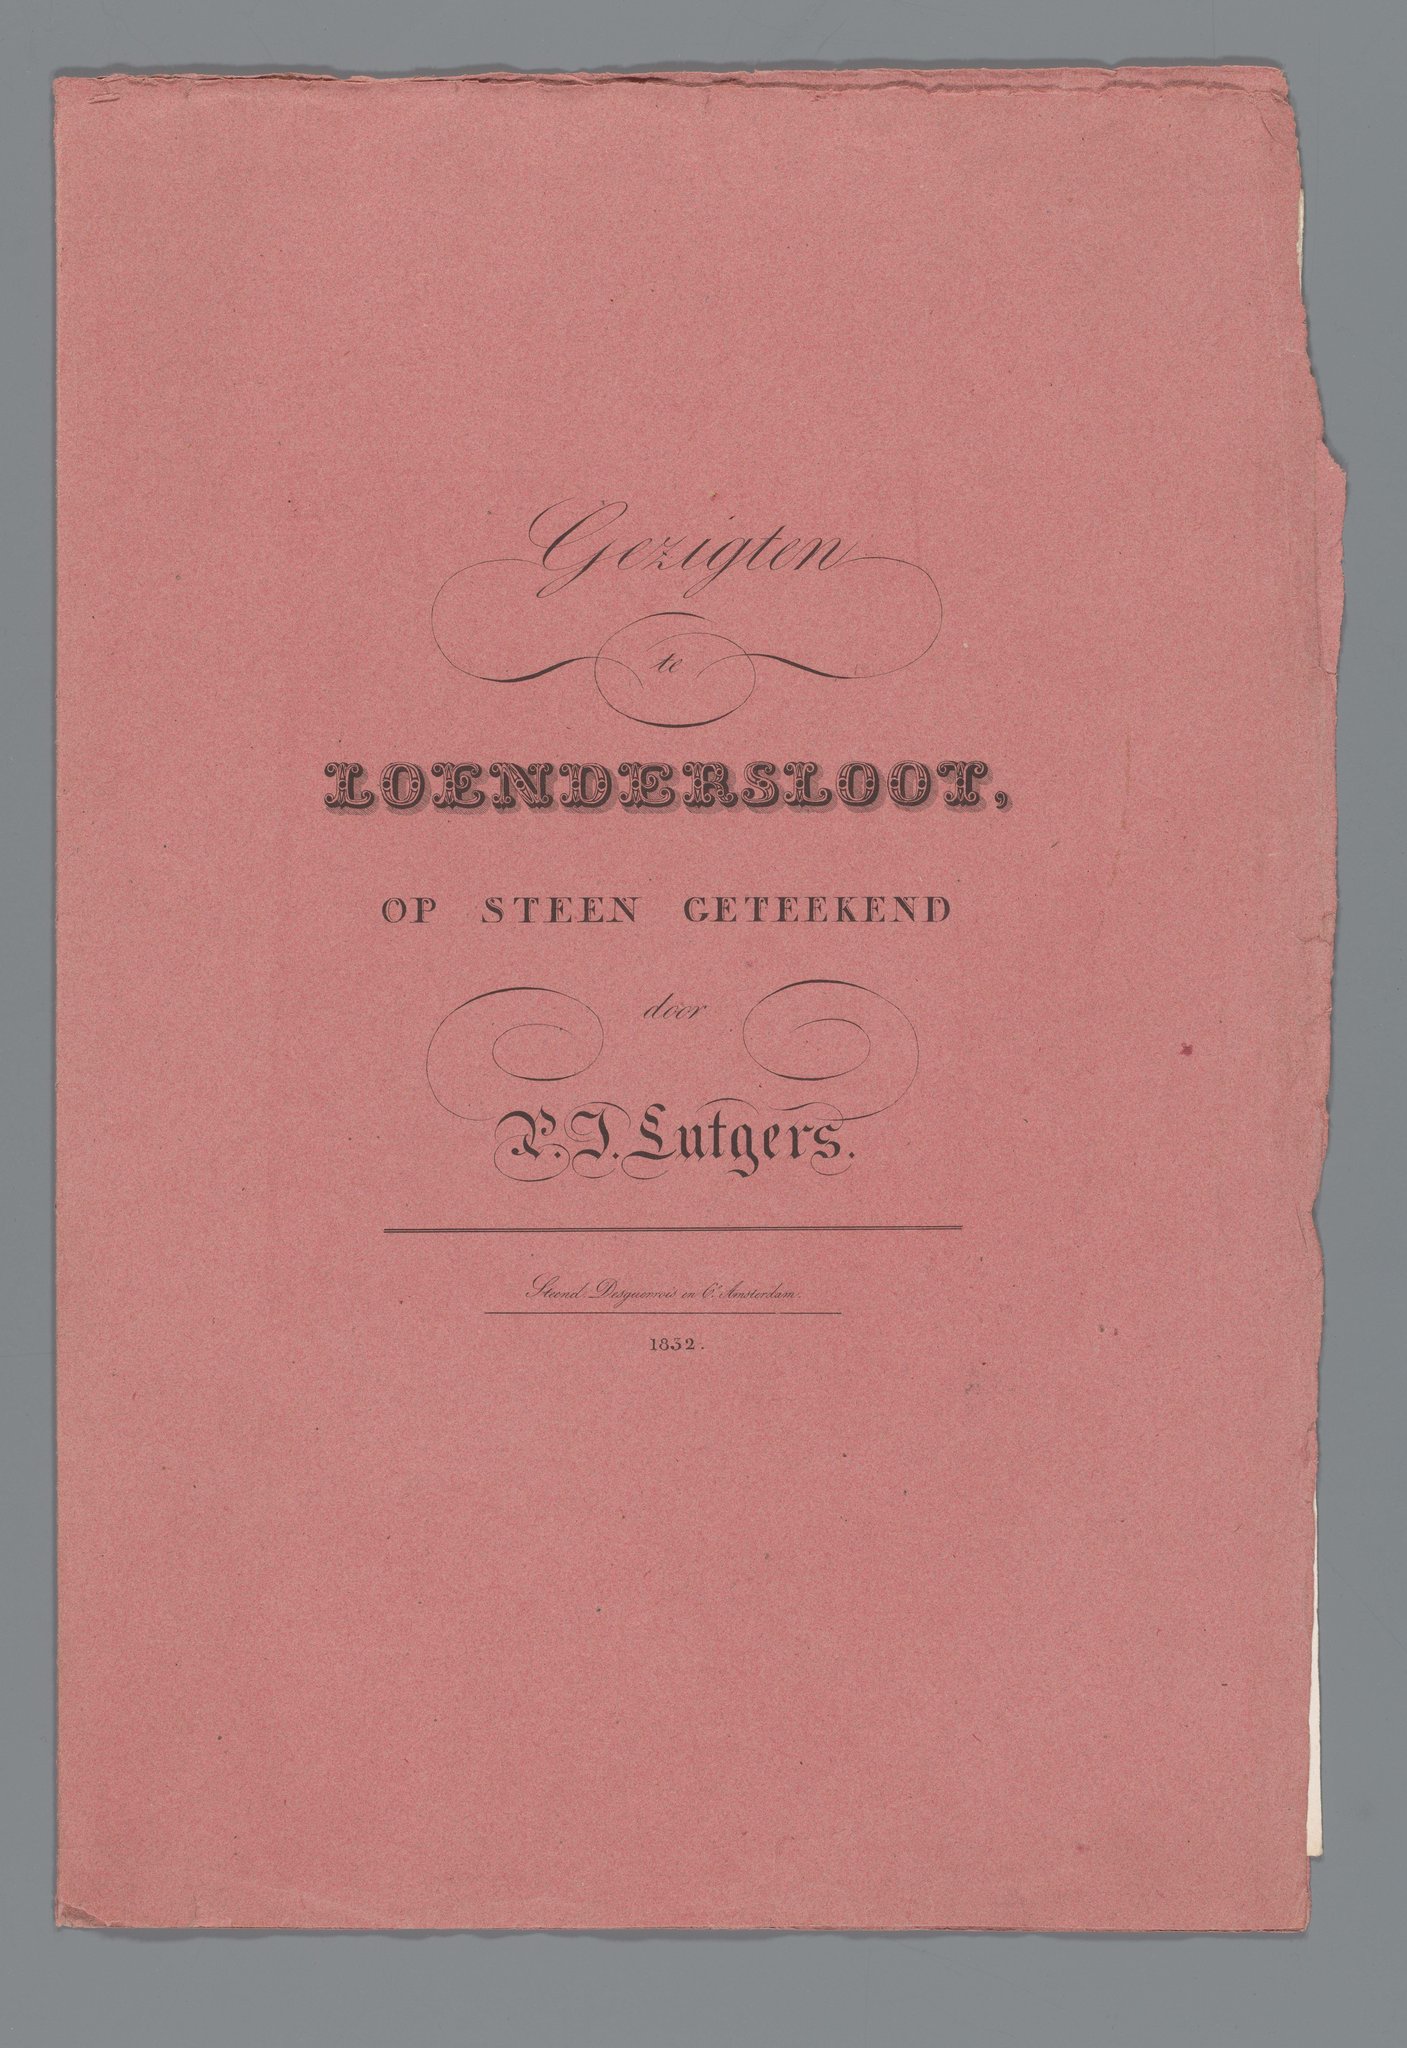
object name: print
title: Gezigten te Loendersloot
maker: petrus josephus lutgers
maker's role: draughtsman, print maker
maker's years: 1808-1874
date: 1832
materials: paper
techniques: lithograph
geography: amsterdam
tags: loenersloot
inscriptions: date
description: Volgens Lisman is deze roze omslag, met vijf titelloze prenten, het begin van de grote serie: Gezigten aan de rivier de Vecht. Lutgers werkte vier jaar aan deze serie, tussen 1832 en 1836. De serie bestaat uit 86 prenten. Mogelijk was Lutgers eerst voornemens om de serie op te delen in meer specifieke gebieden, zoals Loenersloot. Nota bene: De plaats Loendersloot bestaat niet, wel Loenersloot in de gemeente Stichtse Vecht in de provincie Utrecht.